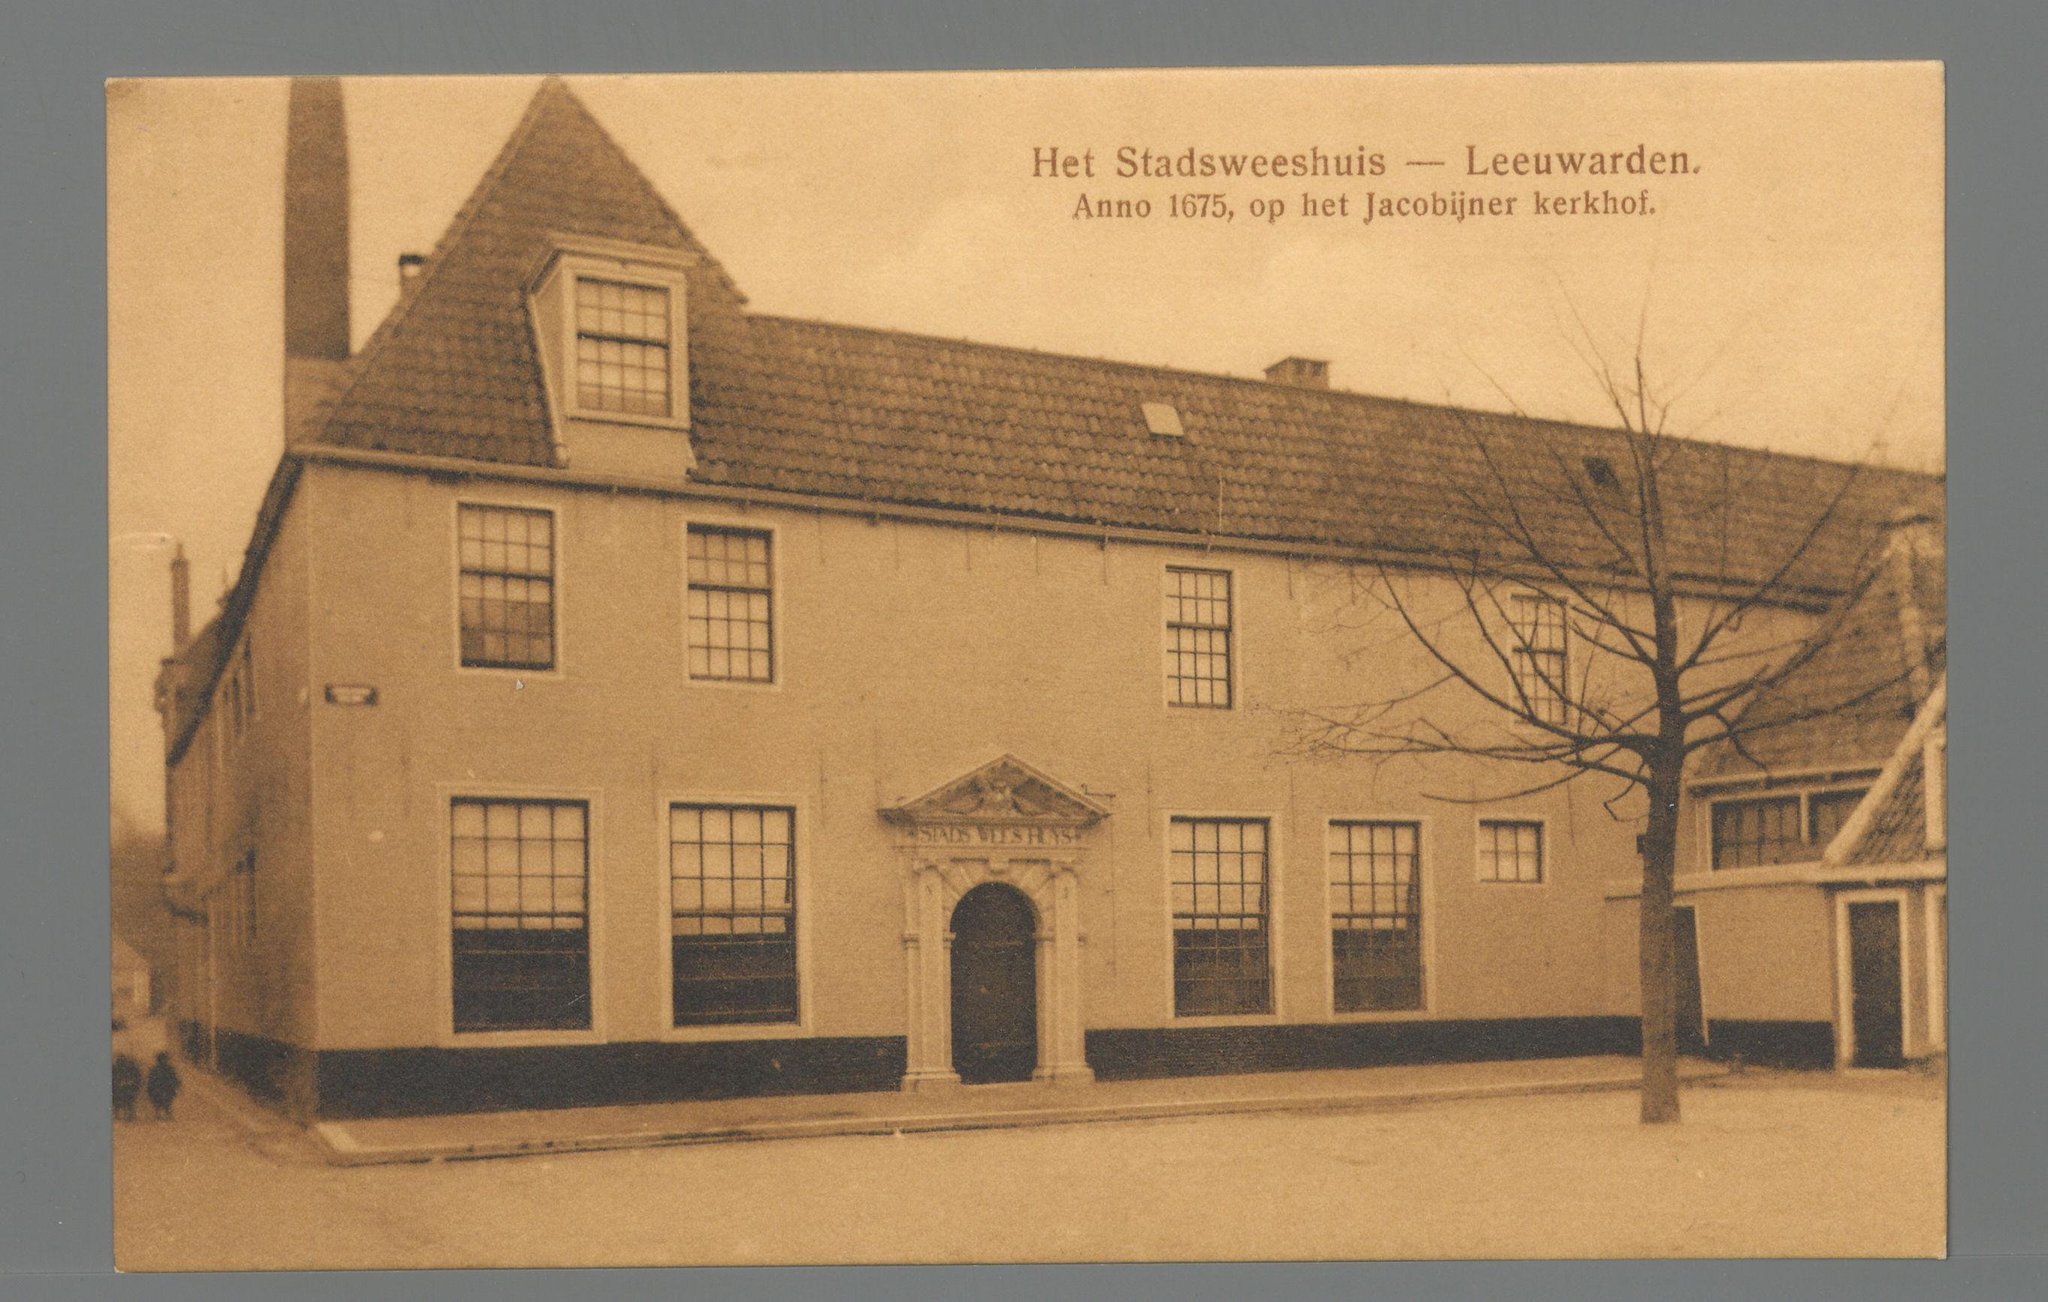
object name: ansichtkaart, prentbriefkaart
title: Het Stadsweeshuis - Leeuwarden. Anno 1675, op het Jacobijner kerkhof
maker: Anonymous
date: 1905-1930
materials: cardboard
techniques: photograph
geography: zwolle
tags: orphanage